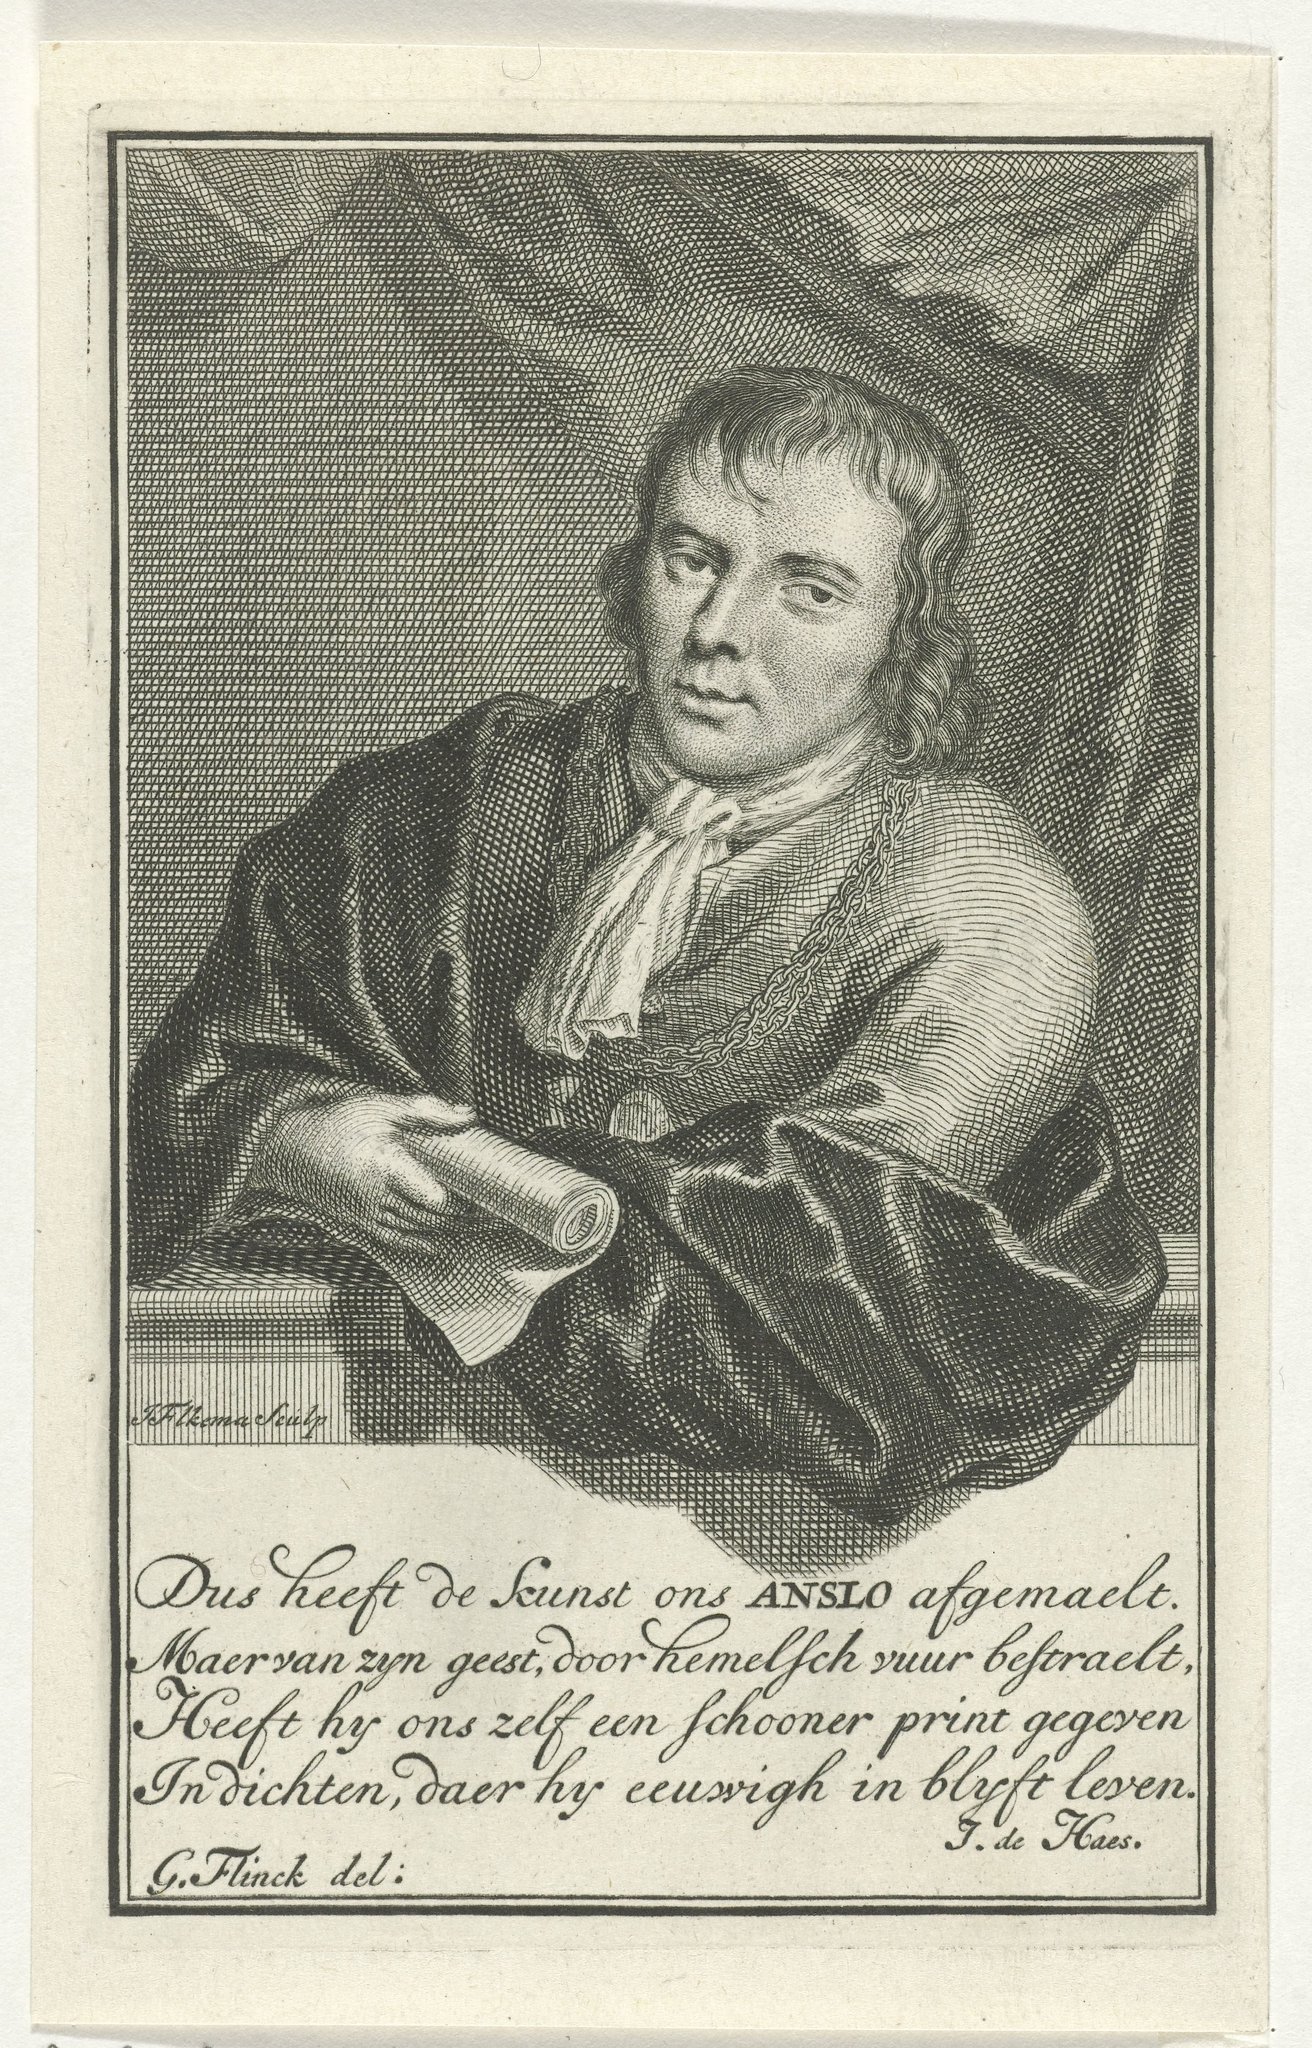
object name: print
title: Portret van Reyer Anslo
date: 1713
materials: paper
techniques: engraving, etching, letterpress printing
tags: amsterdam, reyer anslo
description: Portret ten halven lijve naar links van de letterkundige Reyer Anslo, blootshoofds. In zijn hand houdt Anslo een rol papier. Onder het portret staat een vierregelige tekst in het Nederlands. Op versozijde een tekst in boekdruk.